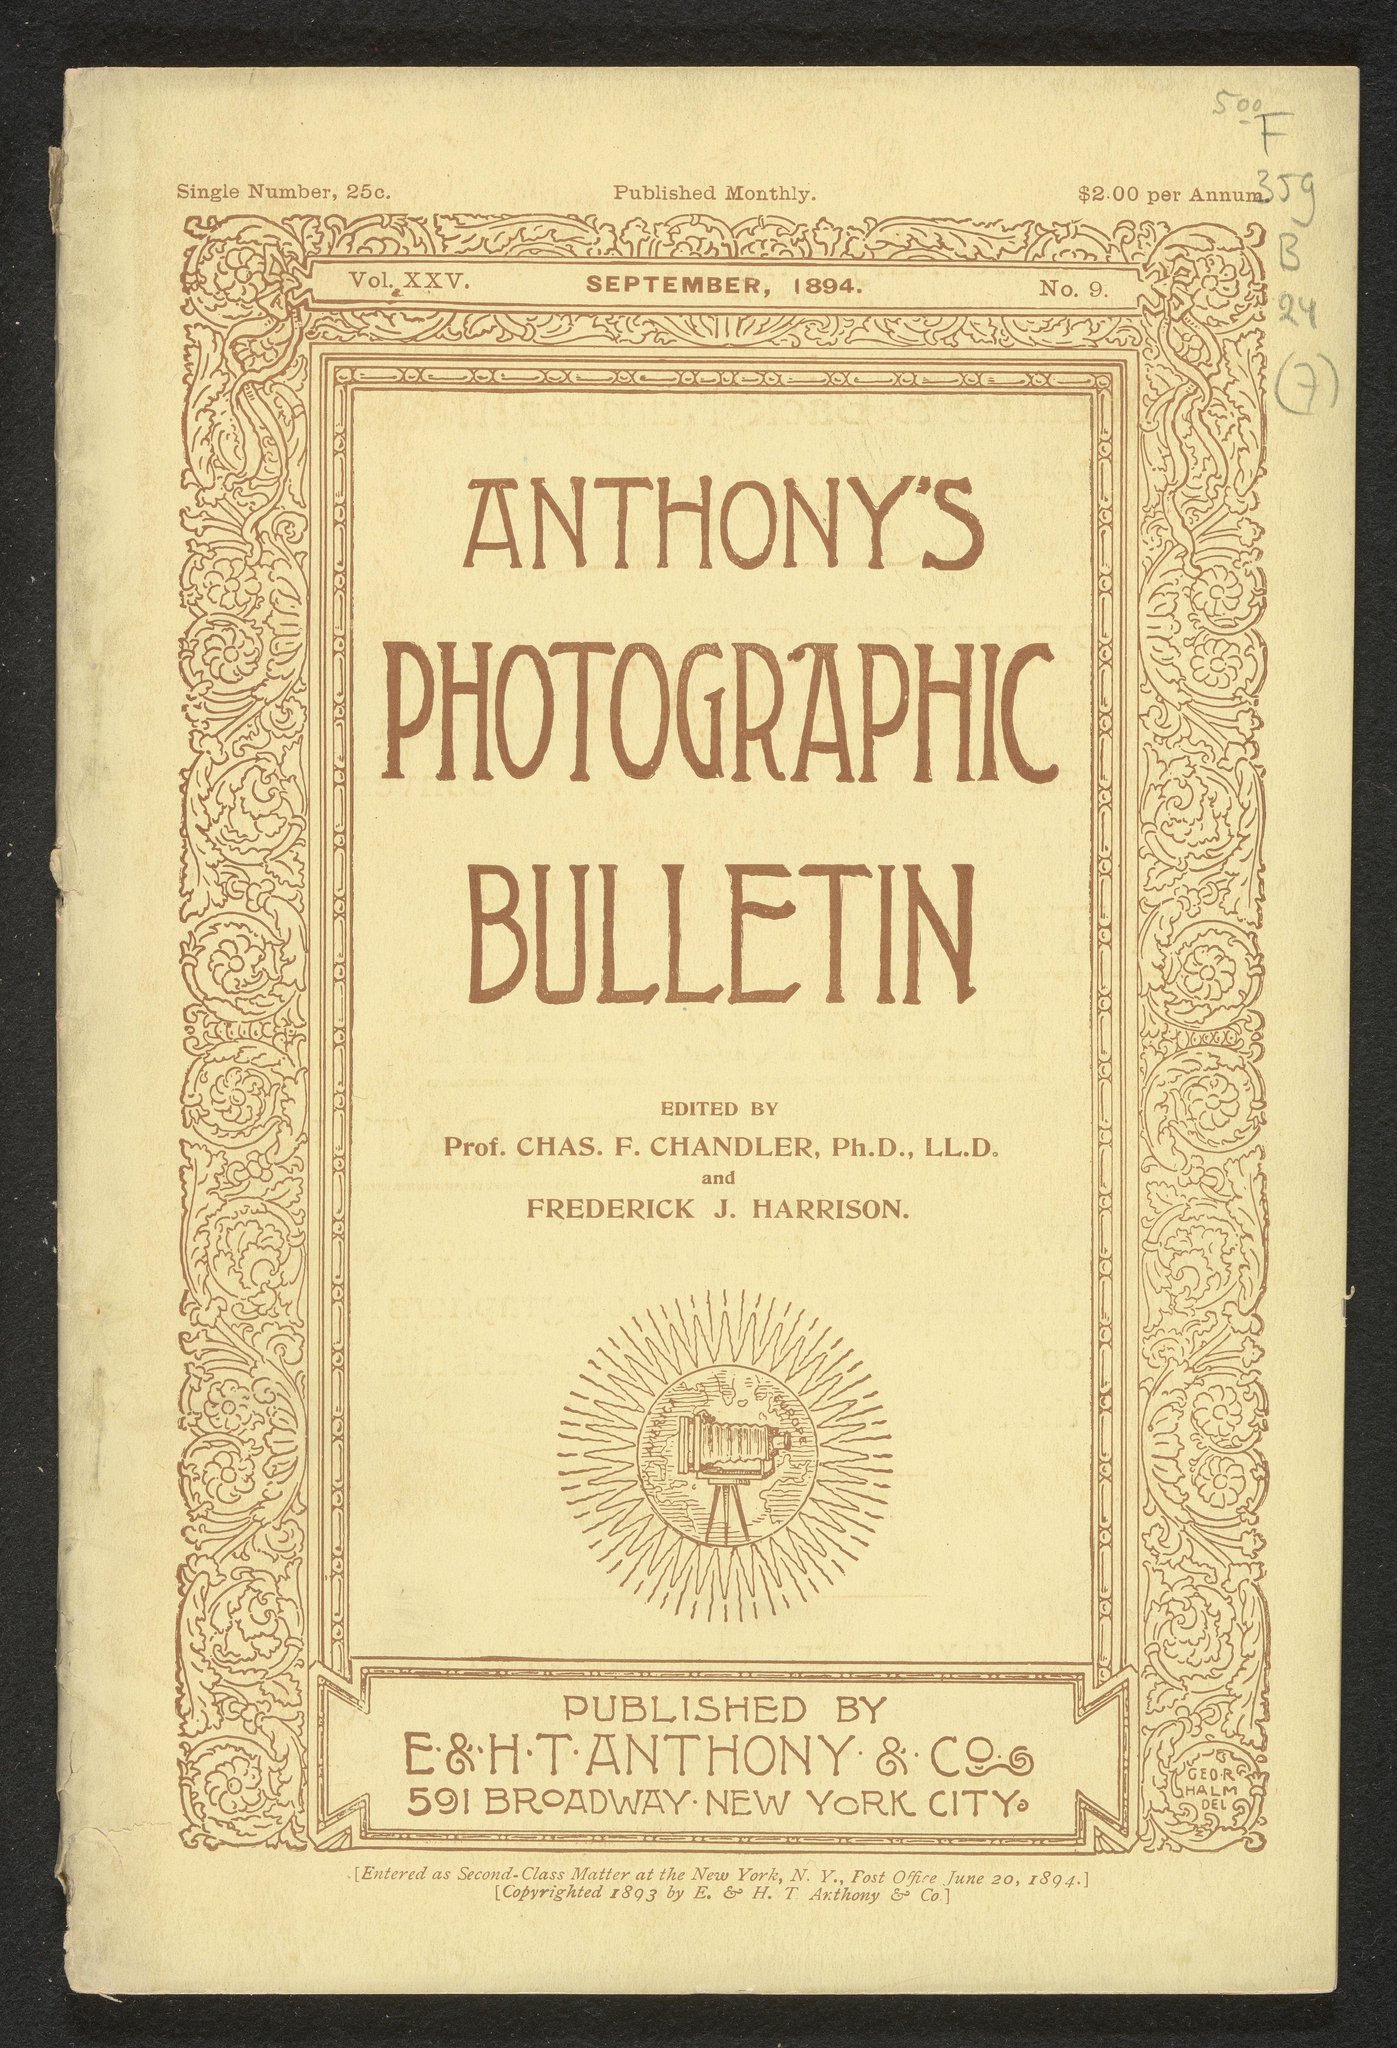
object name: book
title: Anthony's photographic bulletin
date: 1893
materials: paper, photographic support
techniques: printing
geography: new york city